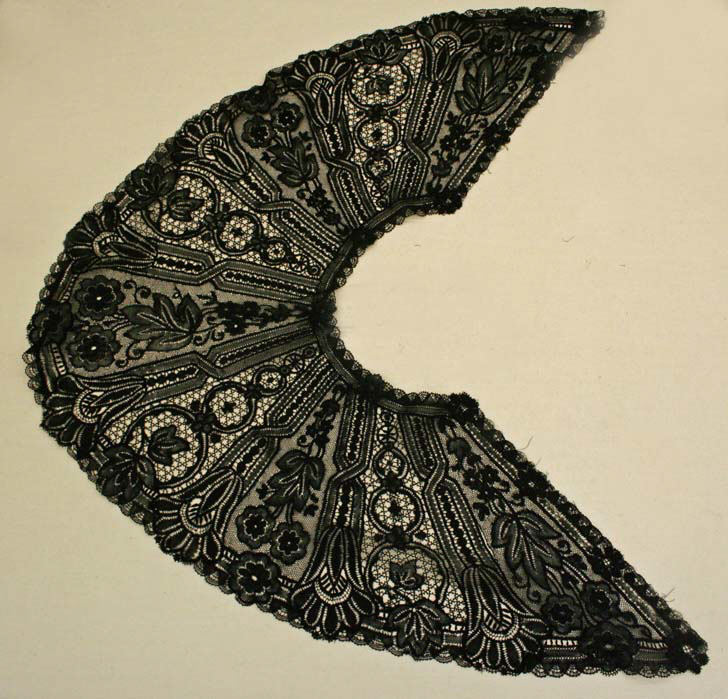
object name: collar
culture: american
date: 1890-1899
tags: flowers